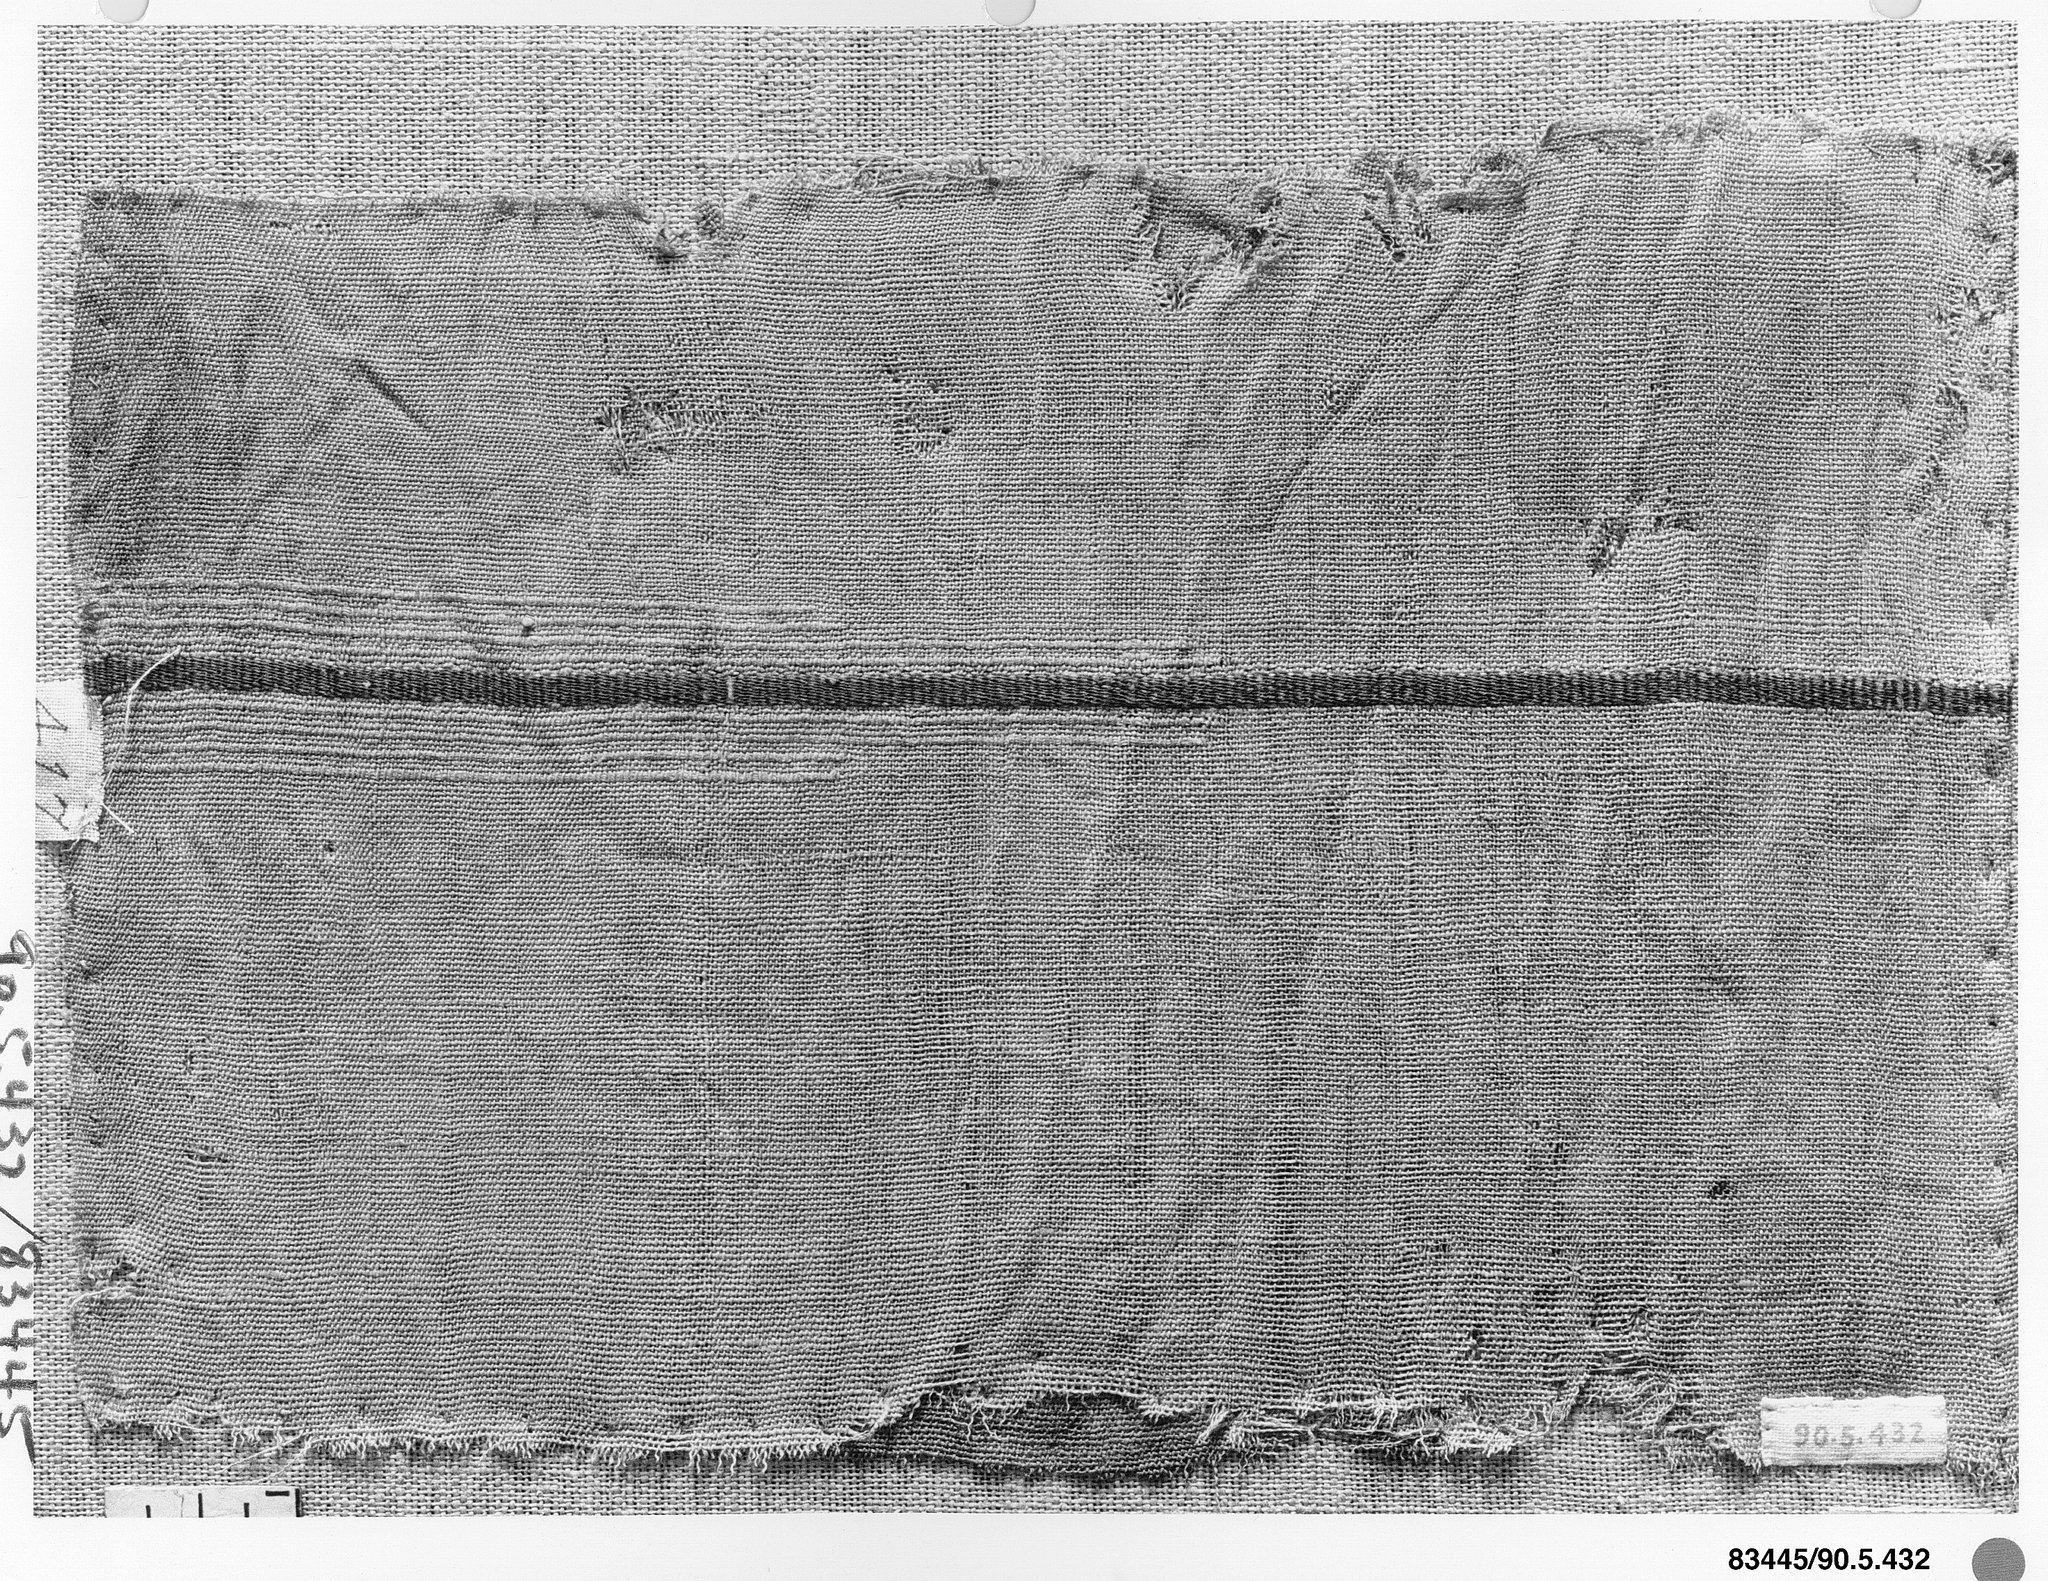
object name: textile fragment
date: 101-300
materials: linen, wool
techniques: weave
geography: egypt